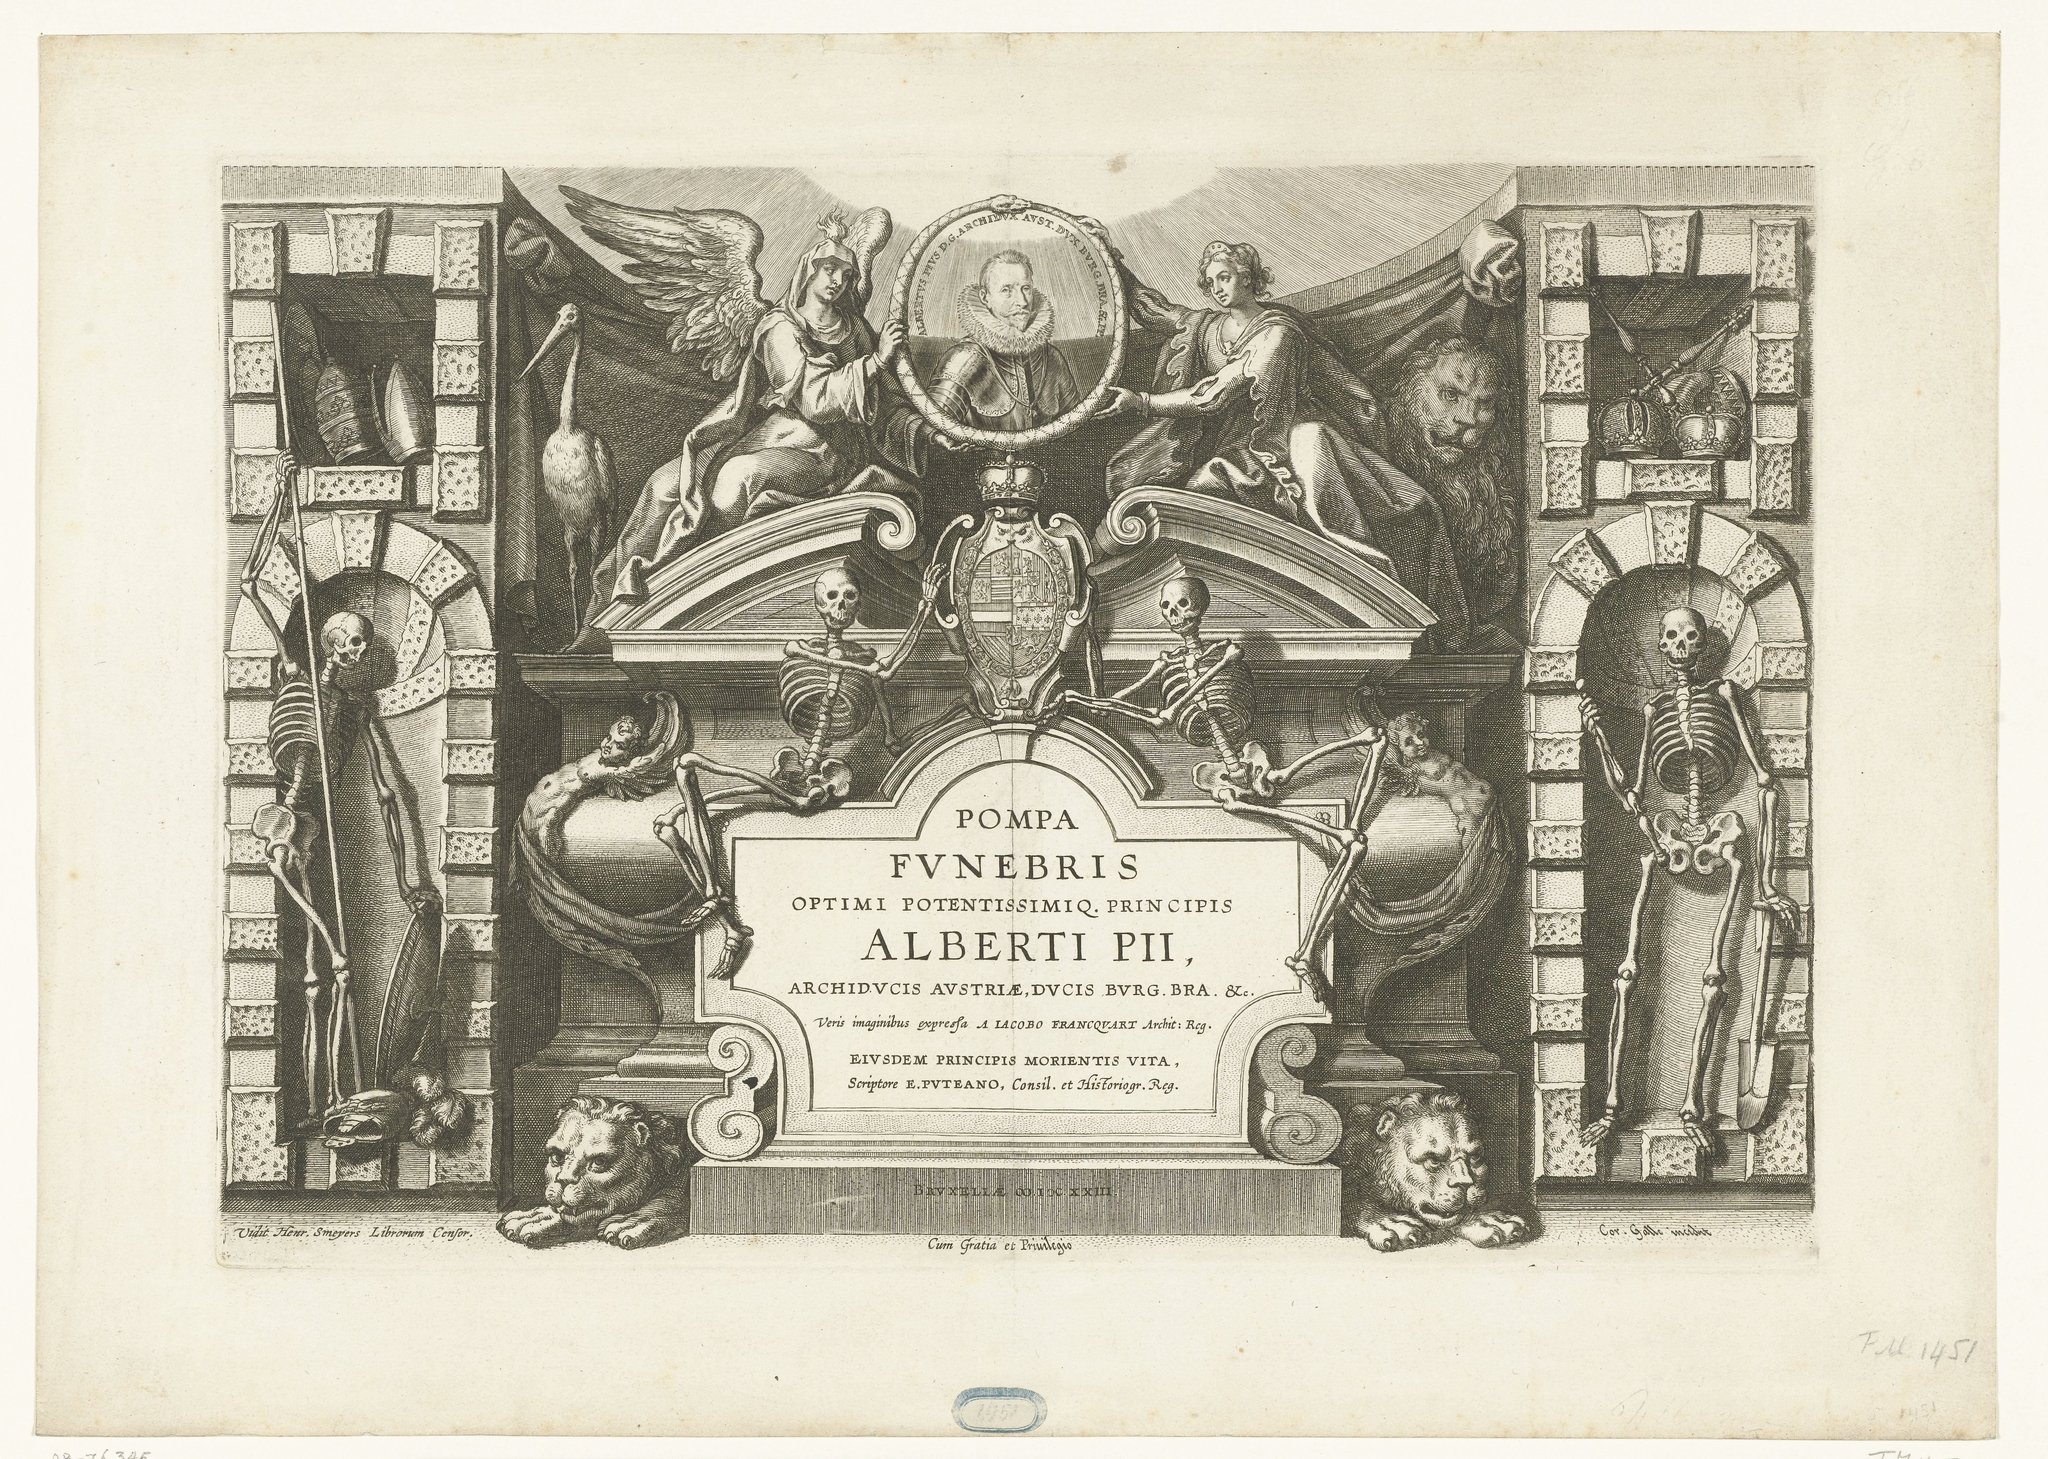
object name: print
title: Begrafenis van aartshertog Albrecht, 1622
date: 1623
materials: paper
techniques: engraving, etching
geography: brussels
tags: brussels, albrecht aartshertog van oostenrijk, death as skeleton, grave-building, monumental tomb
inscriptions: date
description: Titelblad voor de prentserie van de begrafenis van aartshertog Albrecht van Oostenrijk, overleden 13 augustus 1621, begraven te Brussel op 12 maart 1622. Tombe in een muur met geraamtes die het wapen van de aartshertog dragen en het portret van Albrecht vastgehouden door de Waakzaamheid en een andere personificatie.